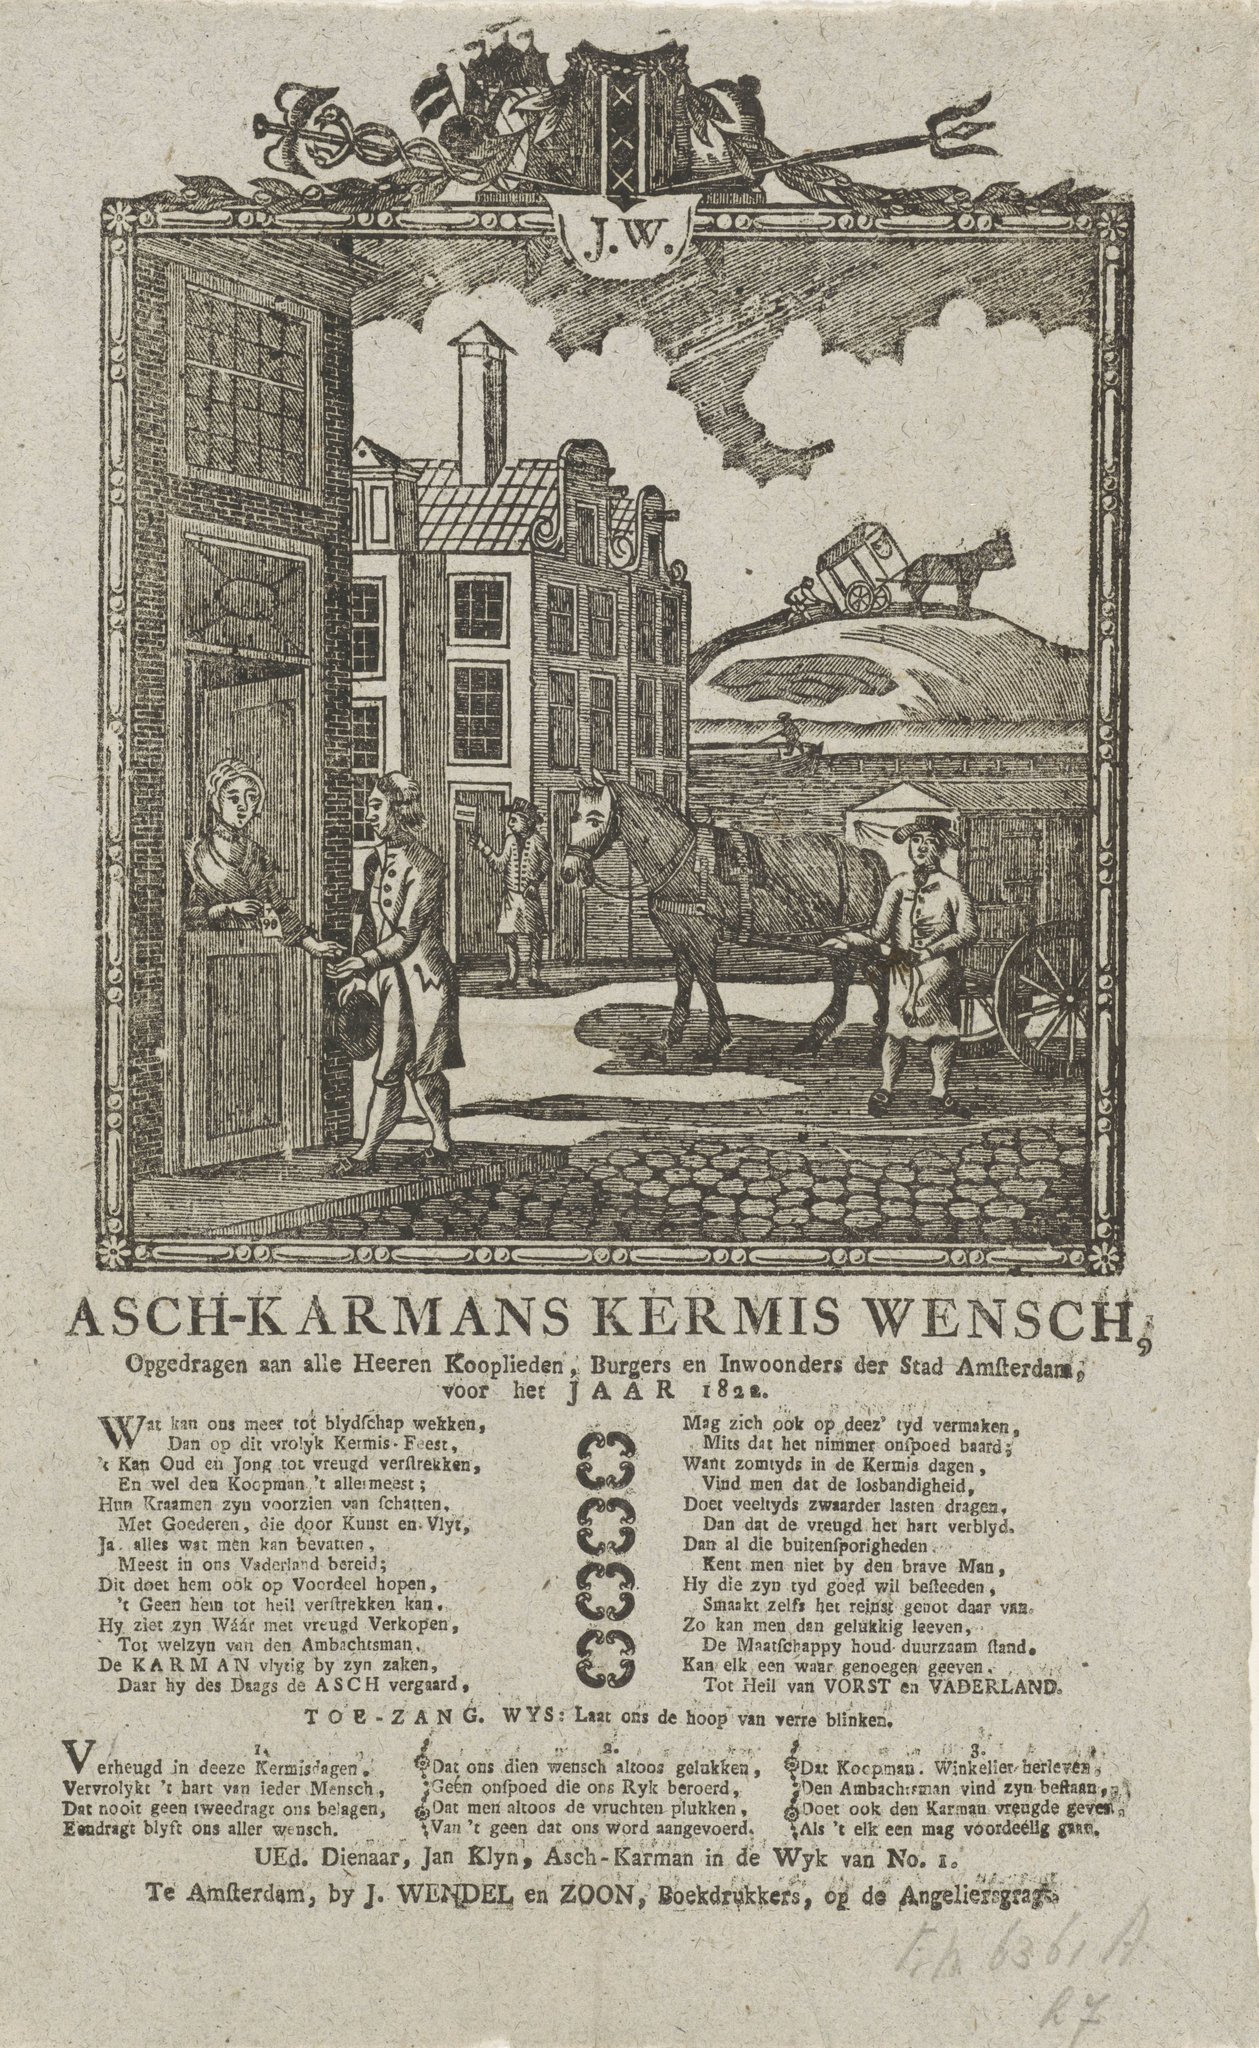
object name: print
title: Asch-Karmans Kermis Wensch (...) 1822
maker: Anonymous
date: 1822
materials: paper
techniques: letterpress printing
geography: amsterdam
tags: public road - ii - ideal city, garbage collection, amsterdam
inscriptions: collector's mark: Lugt 2228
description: Kermisprent namens de askarrenmannen (karrenman of vuilnisman) te Amsterdam voor het jaar 1822. Gezicht in een straat te Amsterdam met de askar, een jongen met een ratel en een man die aan huis geld ophaalt. Op de achtergrond wordt de kar op de asbelt leeggestort. Onderaan een gedicht in twee kolommen en een lied in drie verzen. Namens Jan Klyn, de askarreman van wijk no. 1.